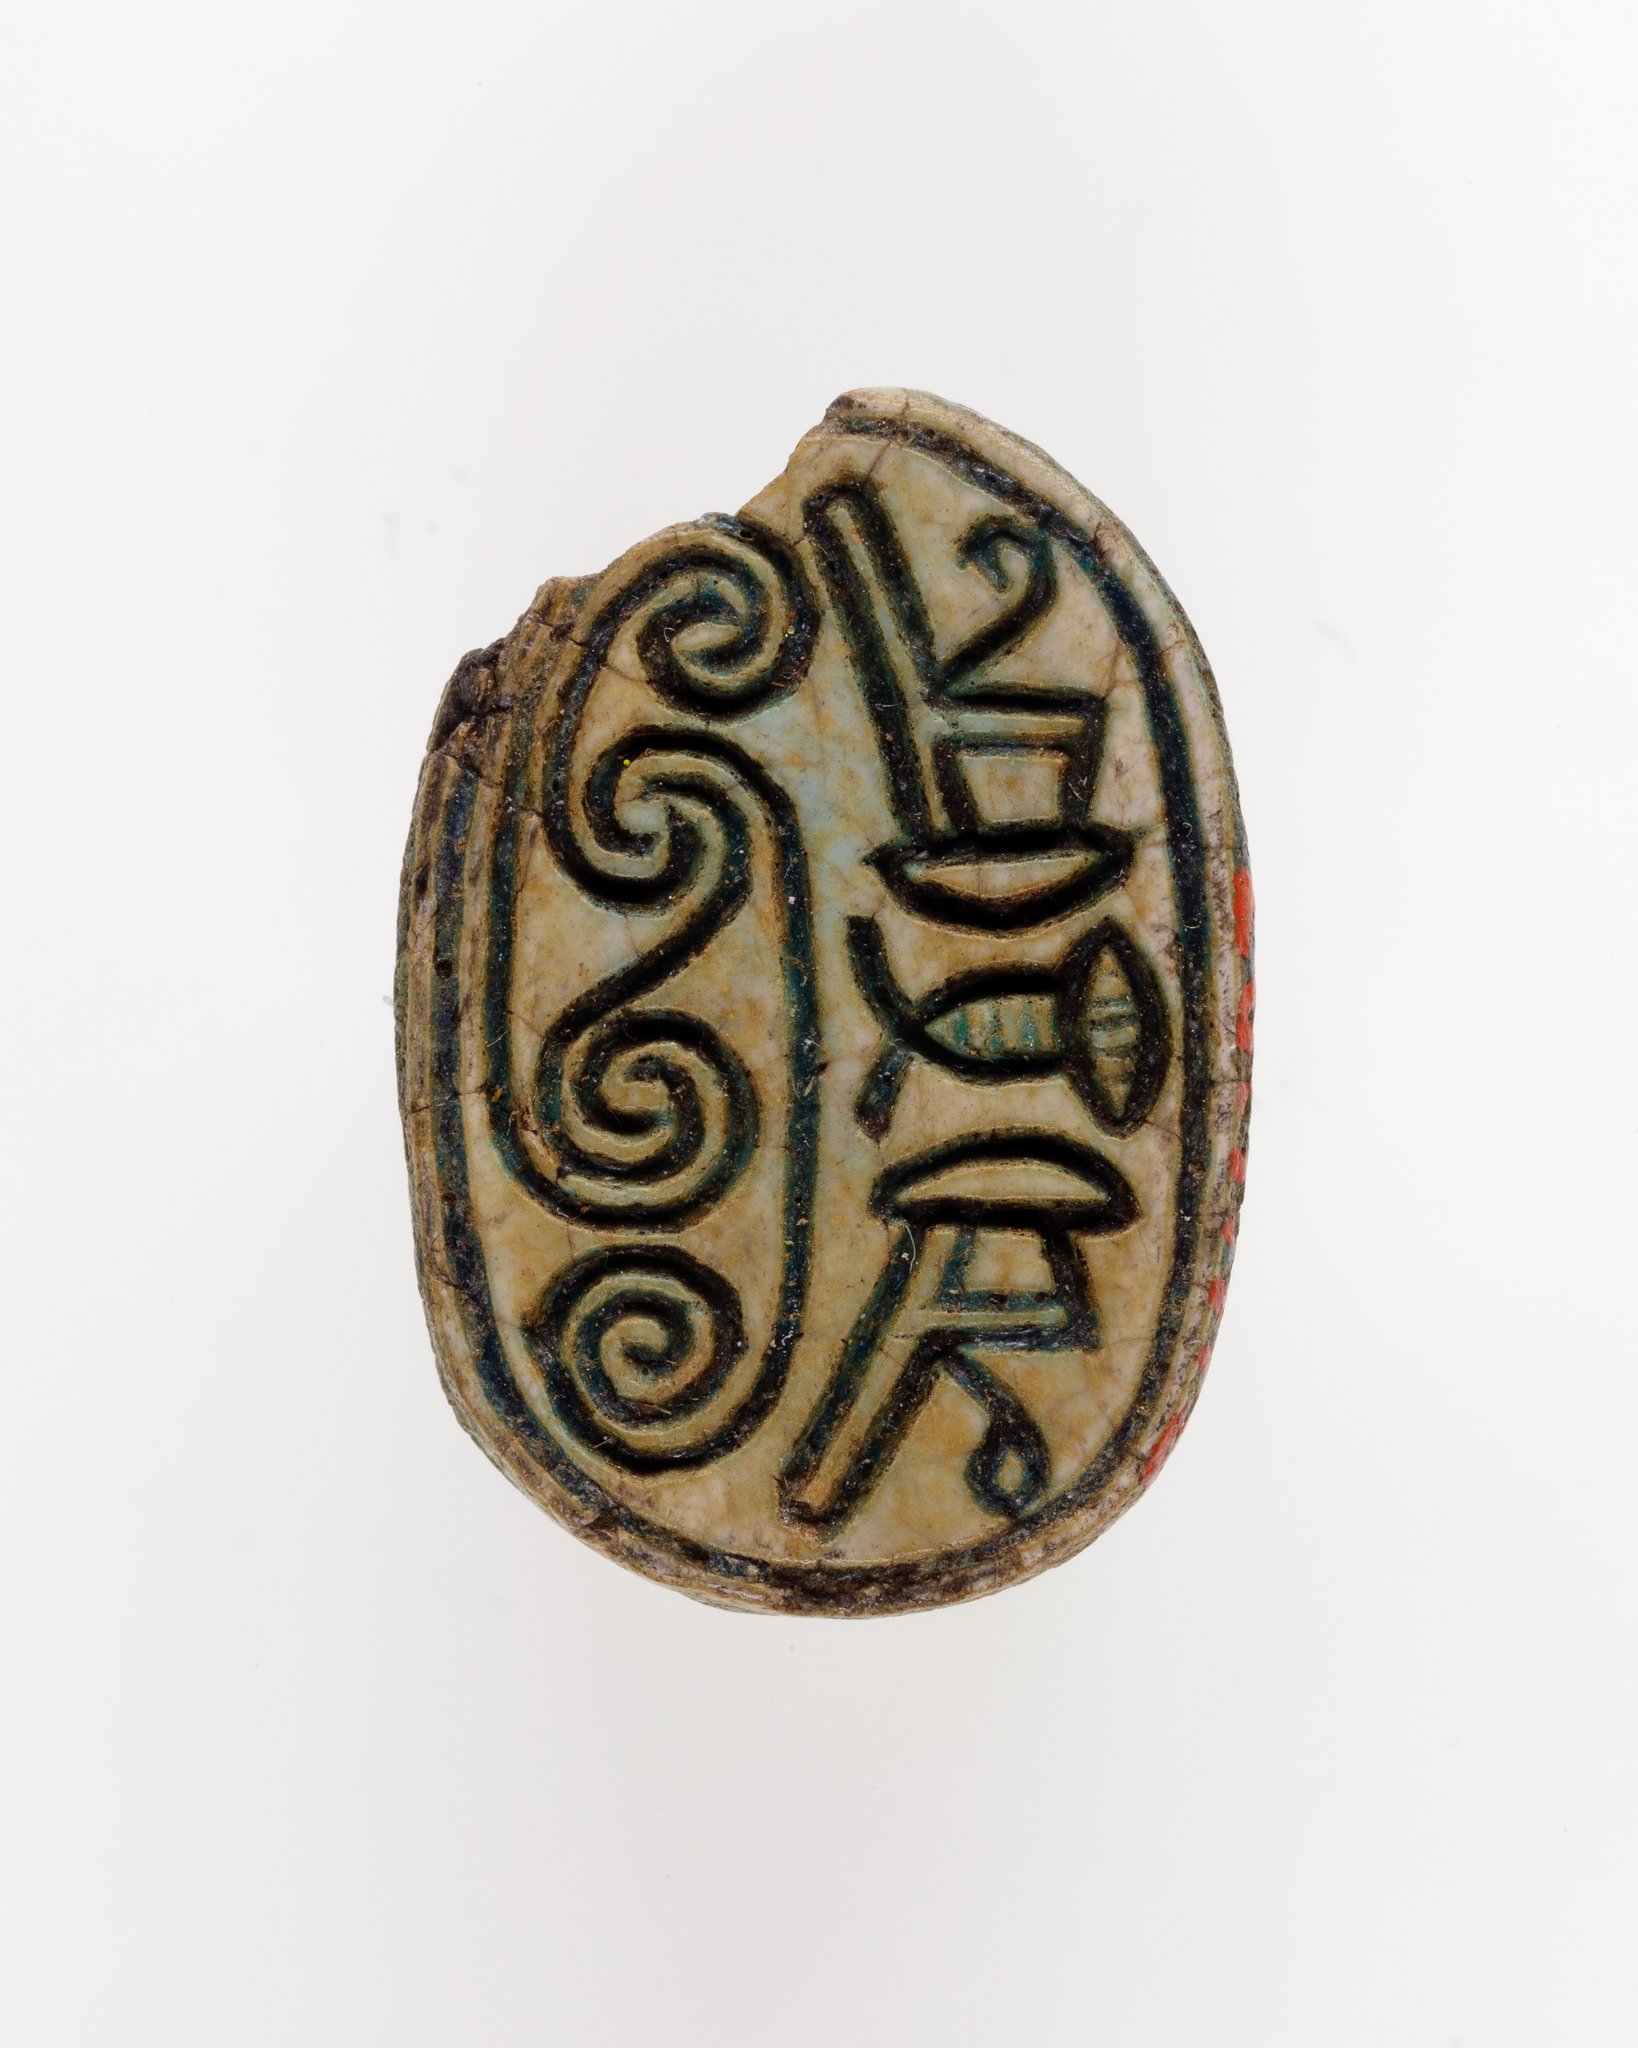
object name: scarab, scroll, red crown, wah hieroglpyh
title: Scarab with Scrolls and Hieroglyphs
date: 1850-1640 BCE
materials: stone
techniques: glazing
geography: egypt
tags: scarabs